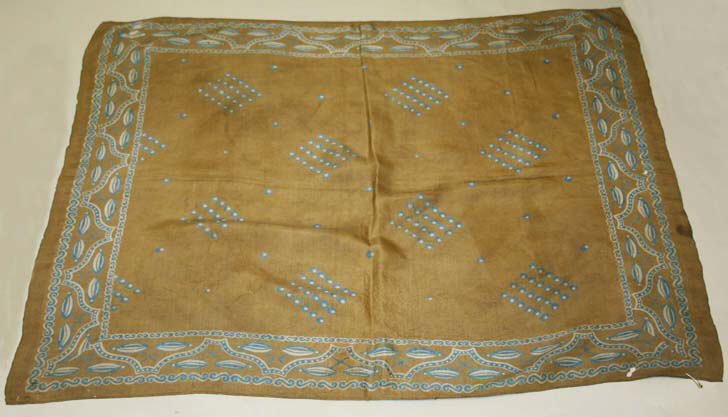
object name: handkerchief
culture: american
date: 1830-1860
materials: silk